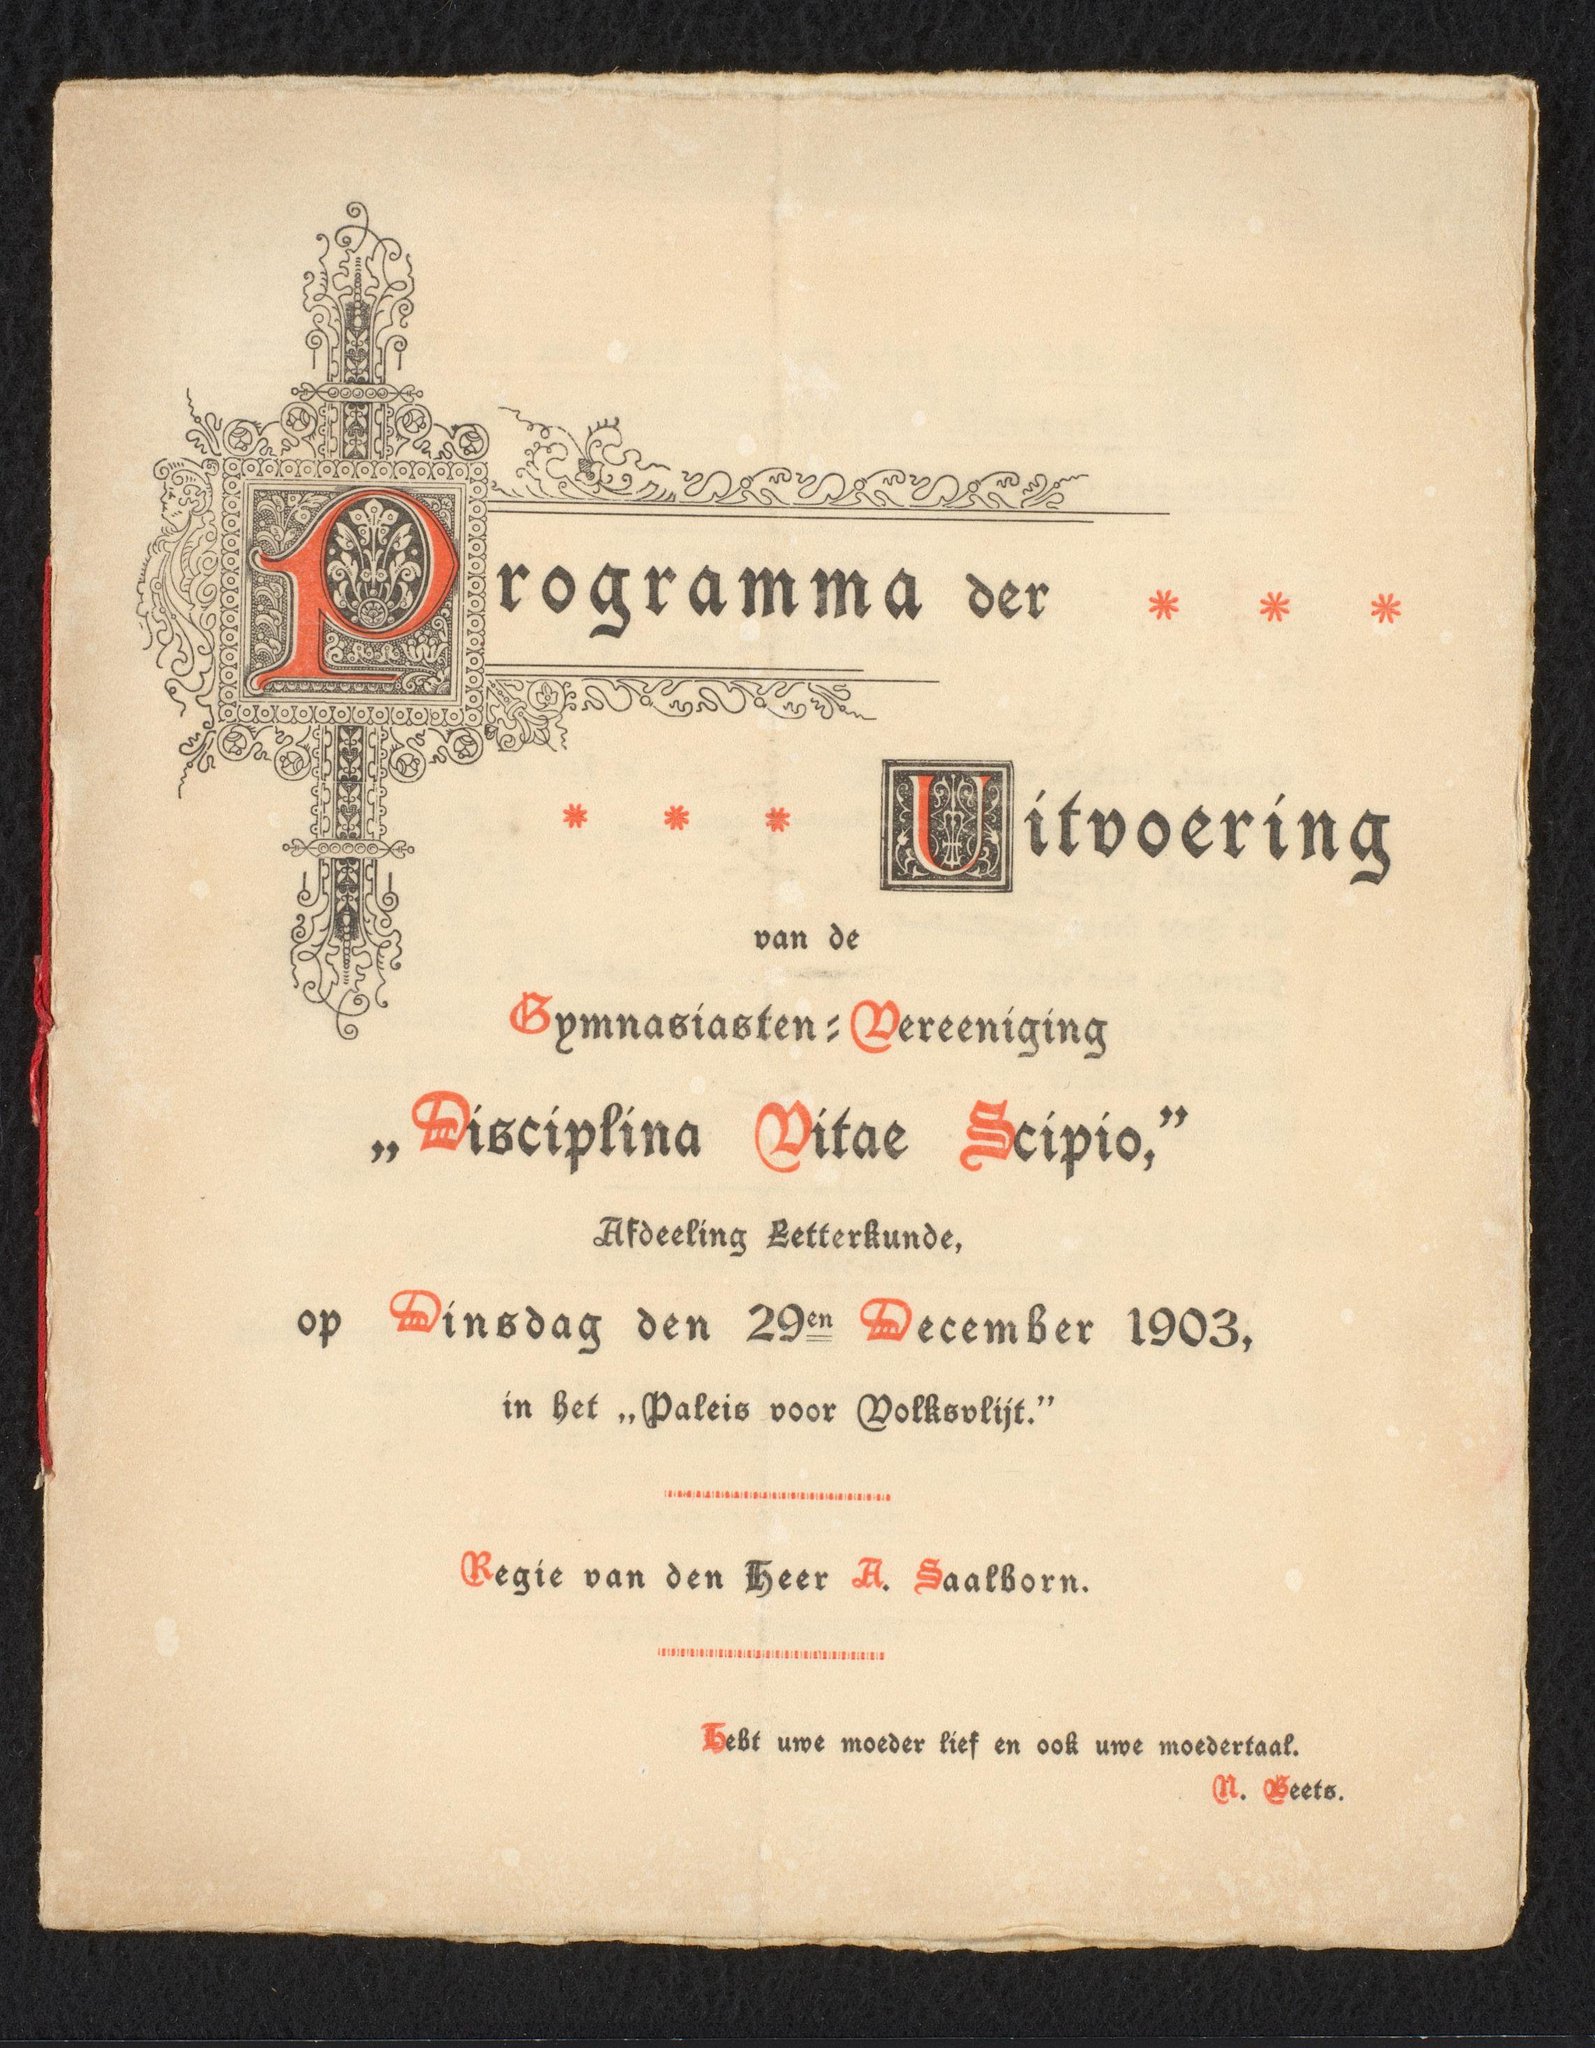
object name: programma, programmaboekje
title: Programma voor de 'Uitvoering van de Gymnasiasten-Vereeniging 'Disciplina Vitae Scipio', afdeeling letterkunde'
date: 1903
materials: paper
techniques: bookbinding, printing block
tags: initial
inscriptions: date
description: Op de voorzijde een ornament rond de initiaal P van het woord 'programma', en verder: 'Programma der Uitvoering van de Gymnasiasten-Vereeniging 'Disciplina Vitae Scipio,' afdeeling Letterkunde, op Dinsdag den 29en December 1903, in het 'Paleis voor Volksvlijt'. Regie van den Heer A. Saalborn'. Binnenin de rolverdeling van de twee stukken ('Het Abelspel van Gloriant' en 'Het Sonnet, Blijspel in 3 Bedrijven, door Fr. van Eeden') en een essay over het Abelspel van Gloriant door W.J. Hofdijk, gedecoreerd met initialen.